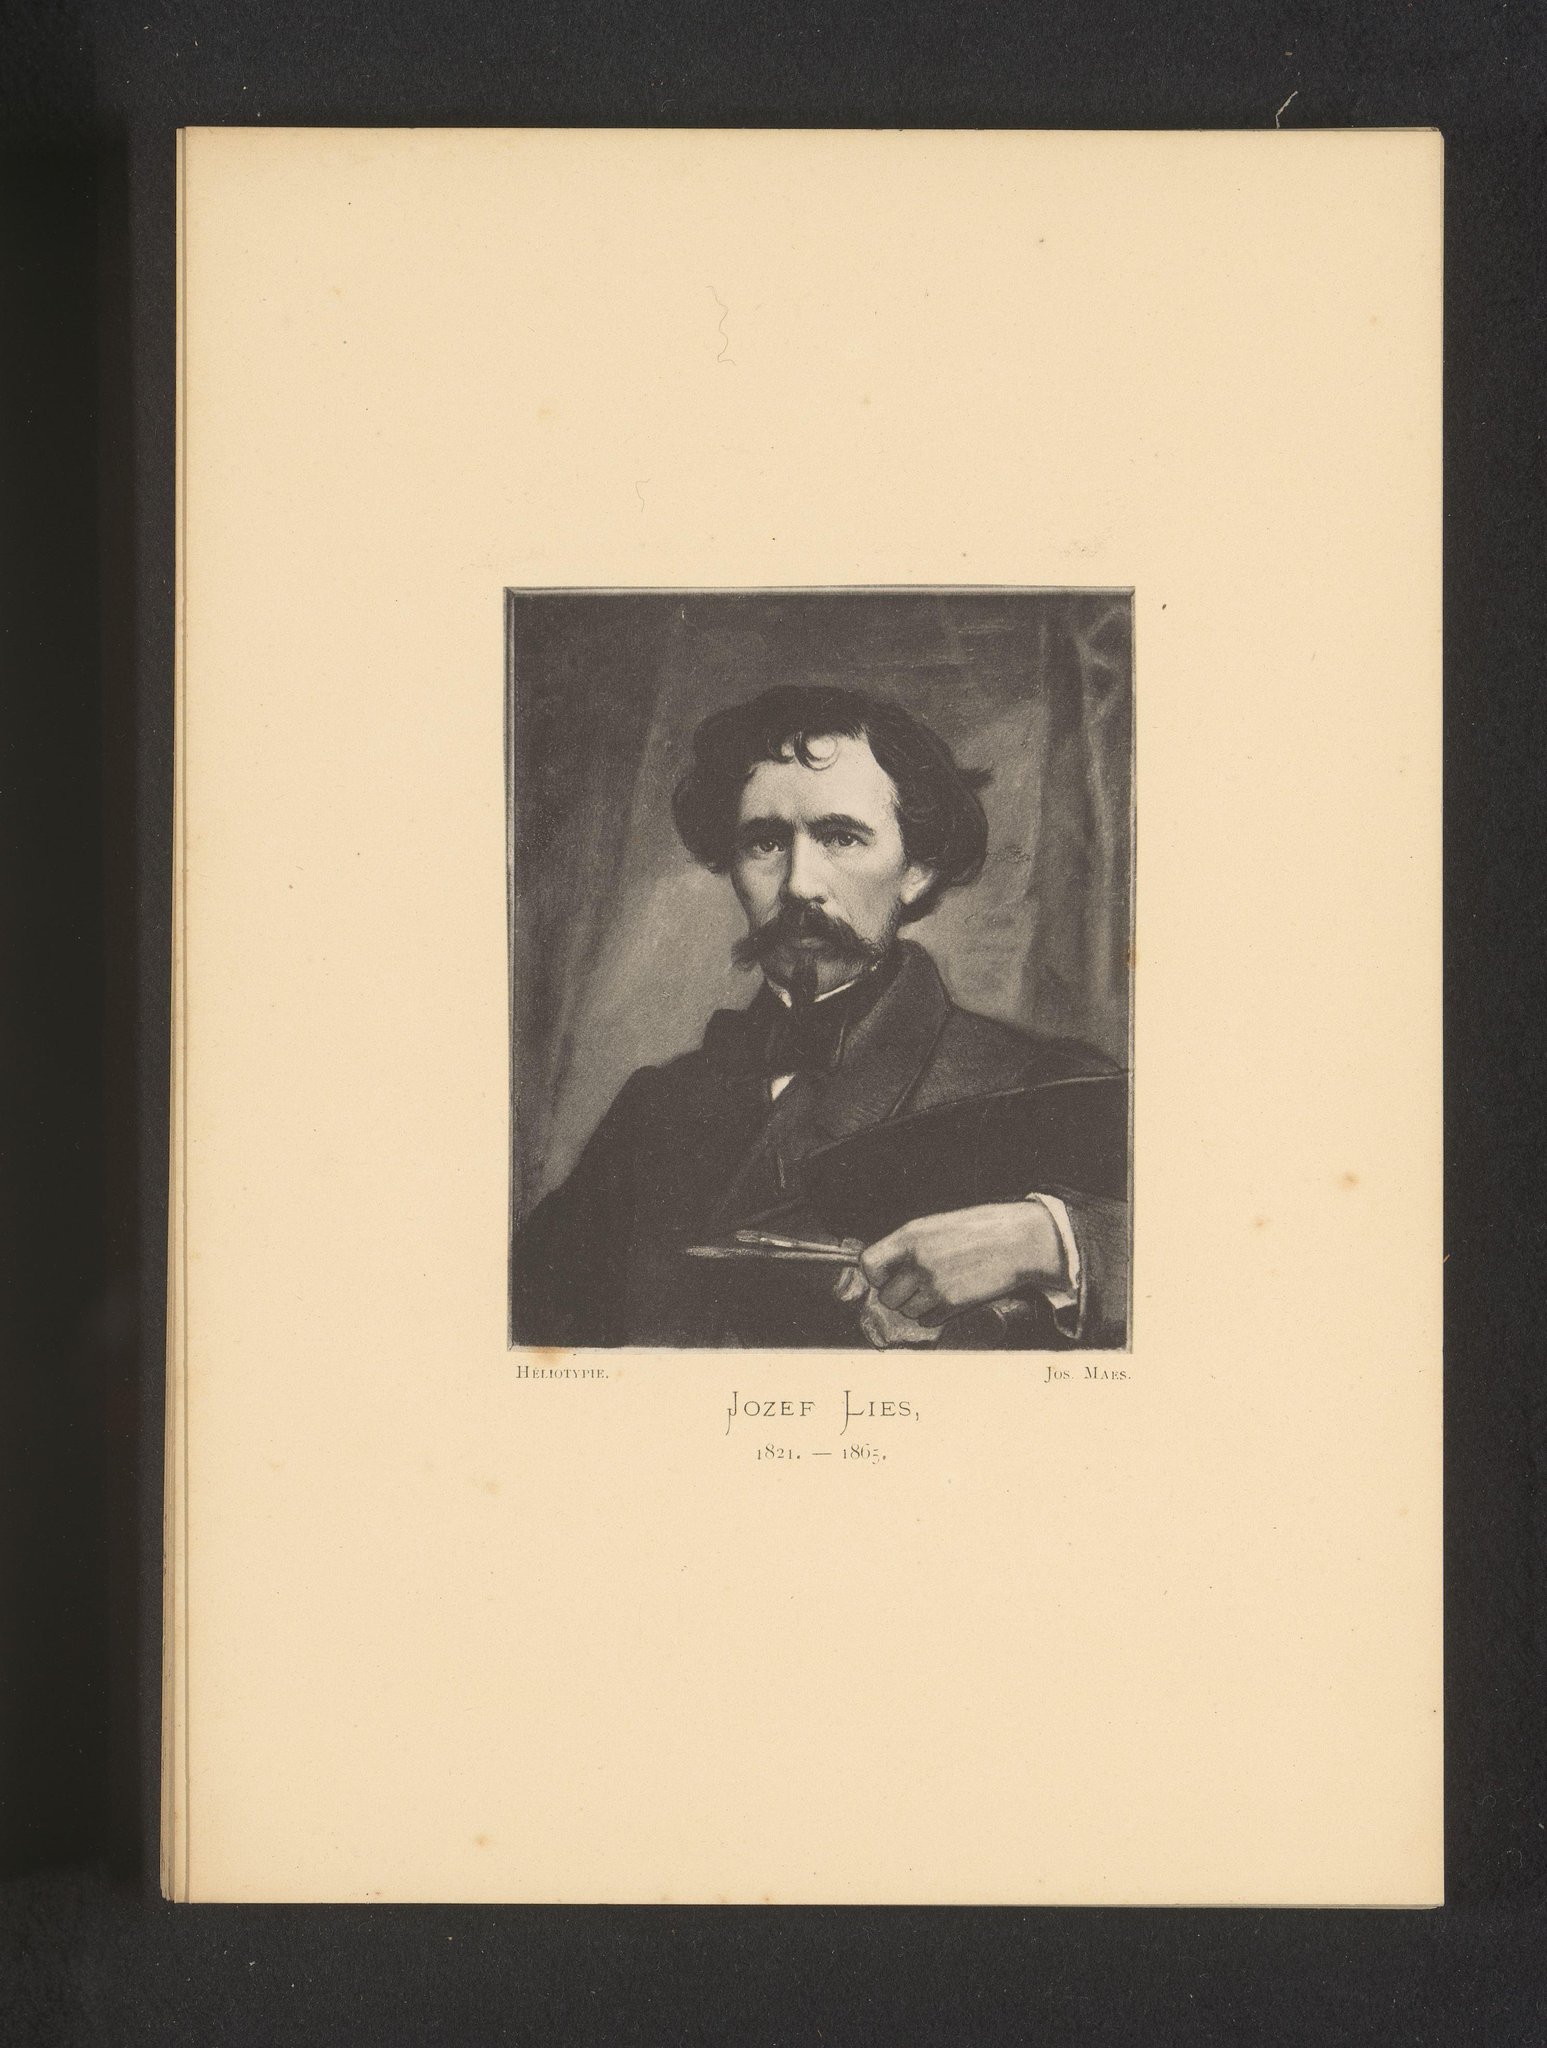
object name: photomechanical print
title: Reproductie van een prent van een portret van Joseph Lies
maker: joseph maes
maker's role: fotograaf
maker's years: 1838-1908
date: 1872-1877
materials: cardboard, paper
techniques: photograph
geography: antwerp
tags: painter, print maker, joseph lies, historical persons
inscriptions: inscription: ‘1821. - 1865.’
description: Deze prent maakt deel uit van een omslag met 150 prenten en een katern met een lijst van afbeeldingen.